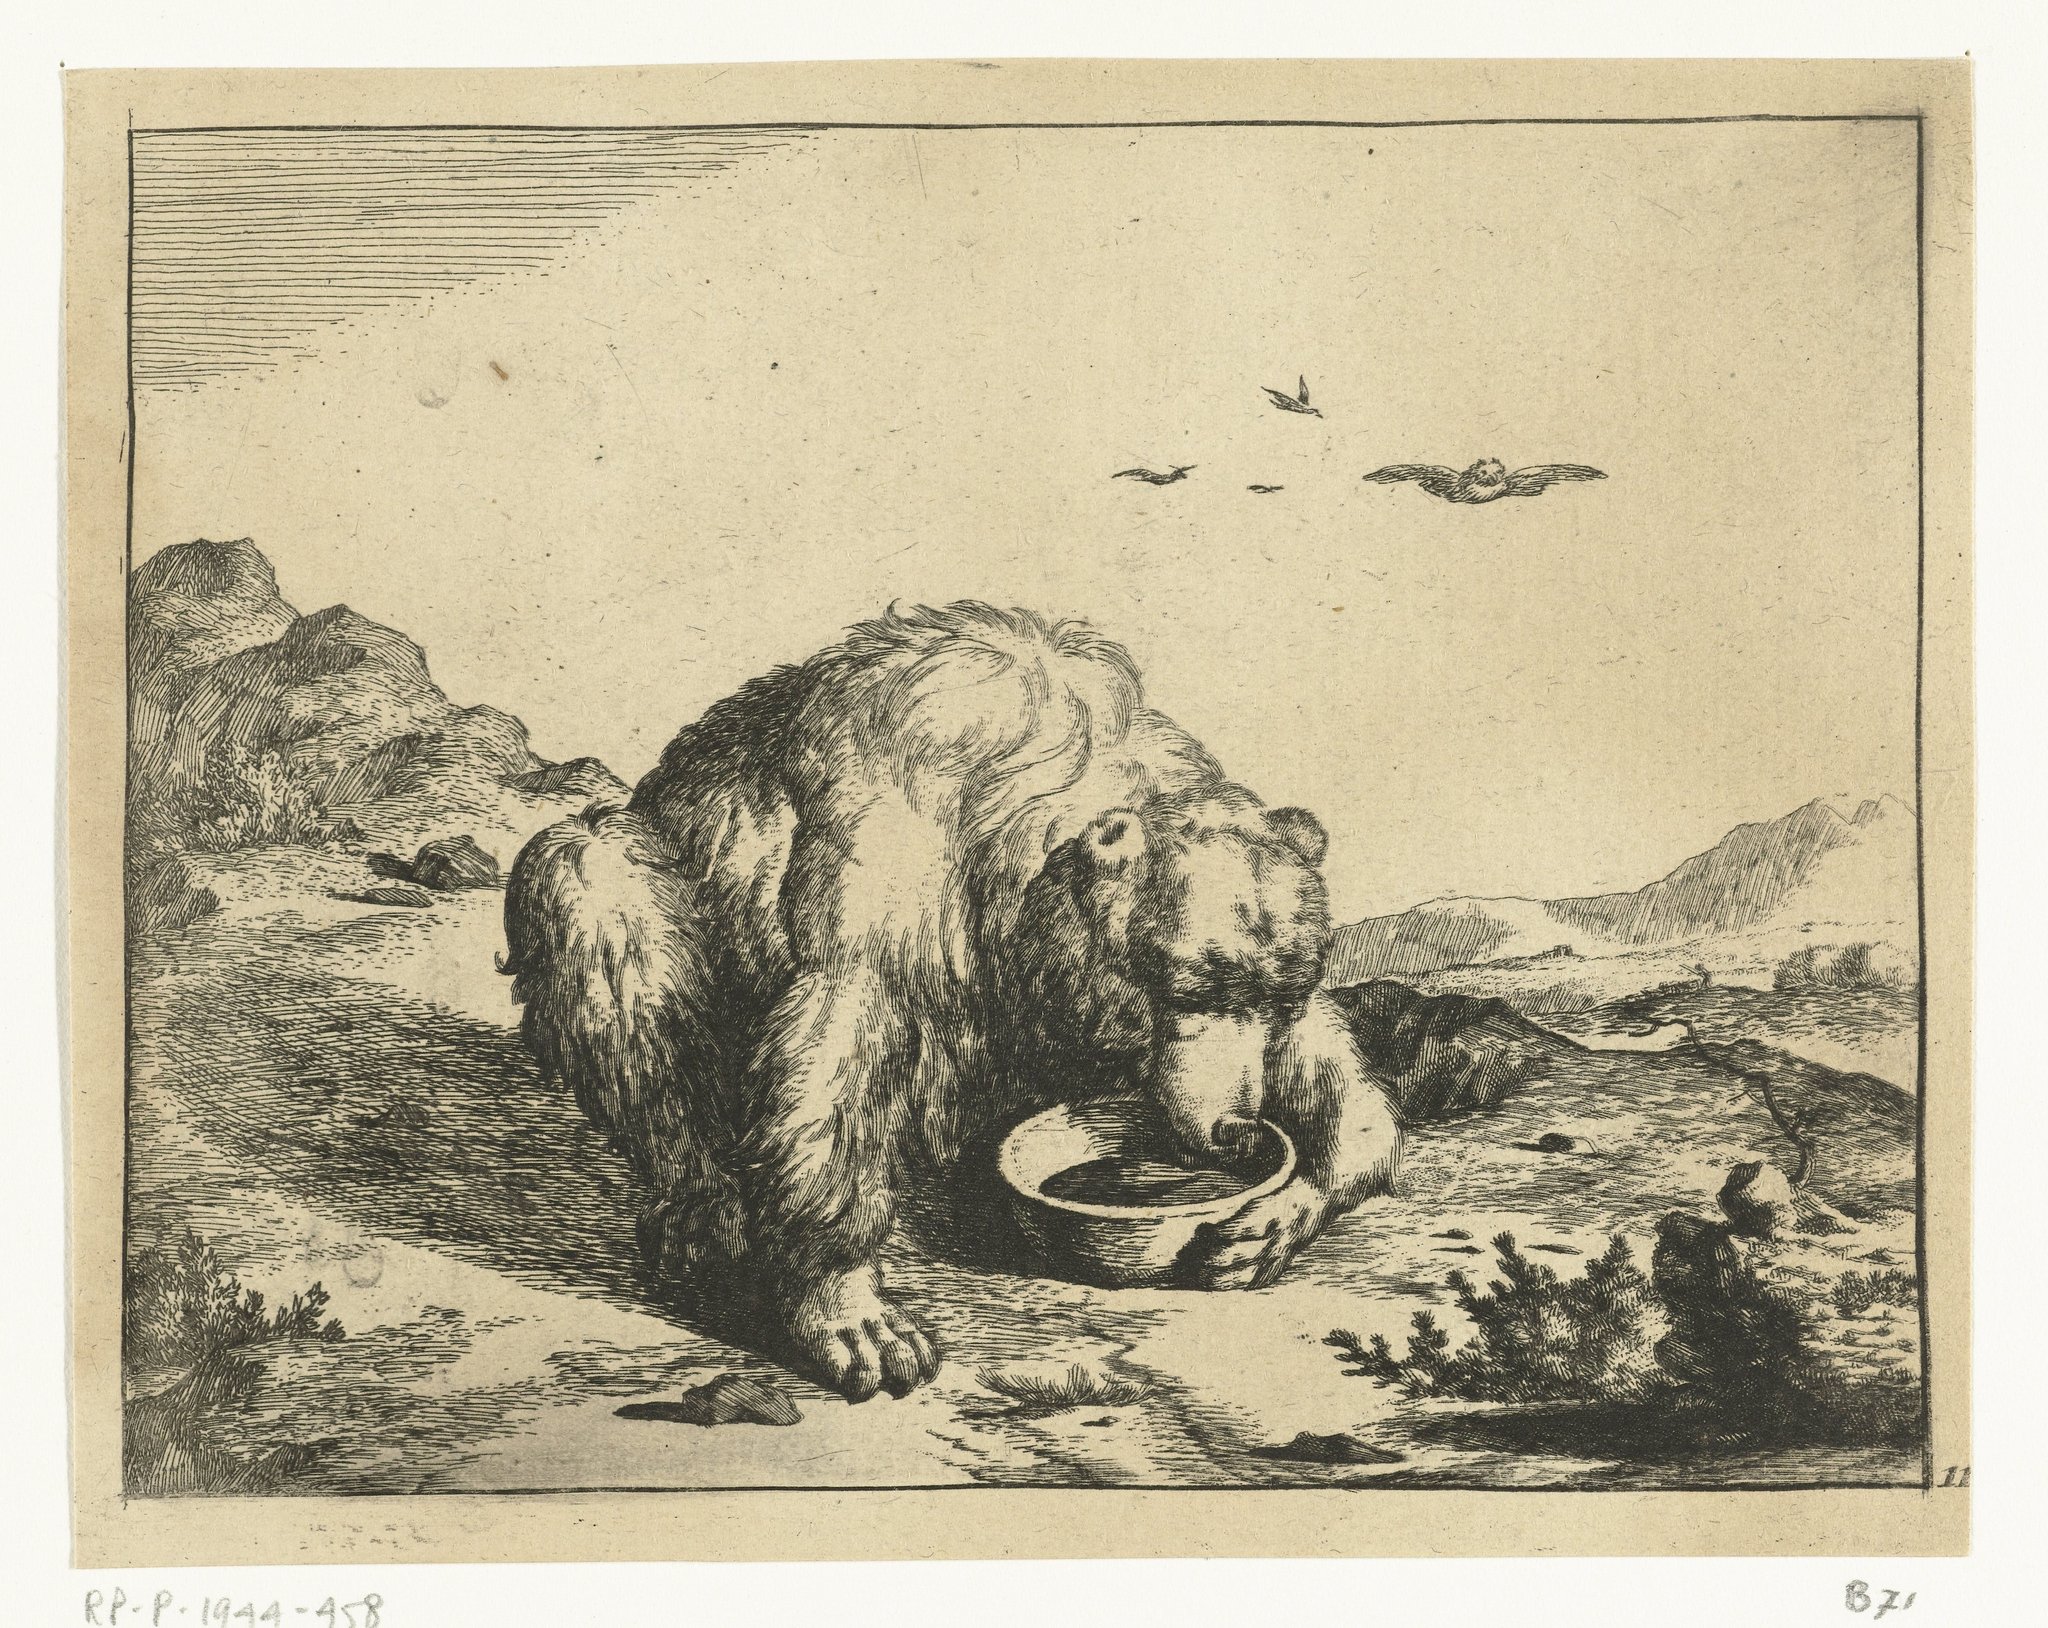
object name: print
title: Beren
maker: marcus de bye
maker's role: print maker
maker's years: 1639-1688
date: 1664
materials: paper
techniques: etching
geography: the hague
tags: beasts of prey, predatory animals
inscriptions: collector's mark: Lugt 2228